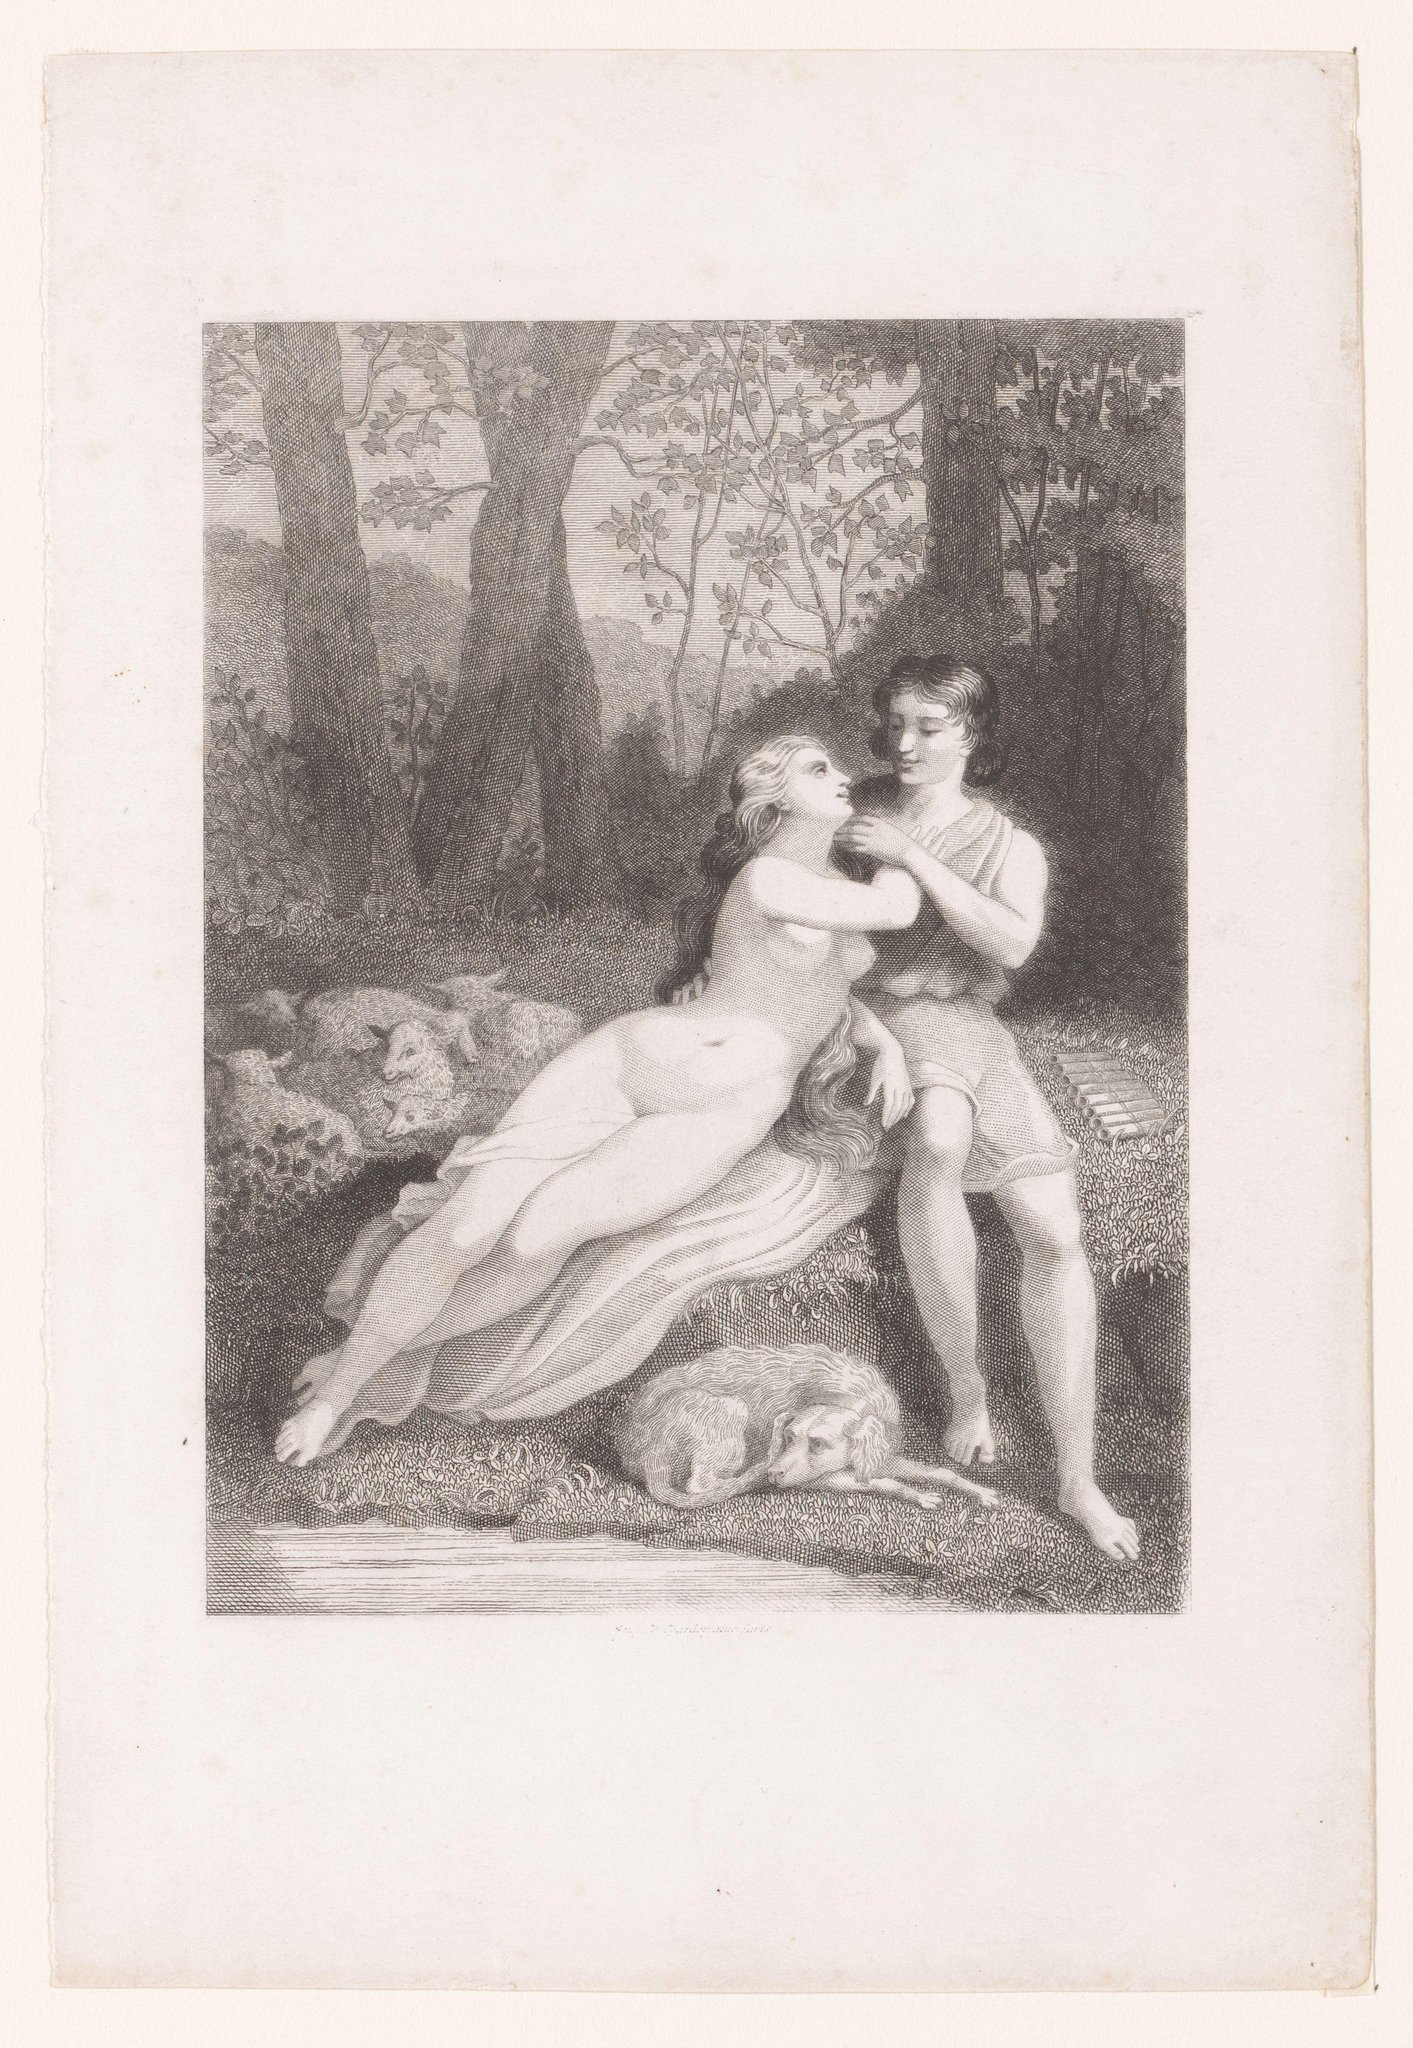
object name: print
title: Daphnis en Chloë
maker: Anonymous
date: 1820-1860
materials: paper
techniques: engraving, etching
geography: paris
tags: daphnis (in greek mythology a shepherd who invented pastoral poetry, chloe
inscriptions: collector's mark: Lugt 2228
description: Compositie geïnspireerd op "Venus en Adonis" van Pierre Prud'hon, maar bewerkt tot Daphnis en Chloë.